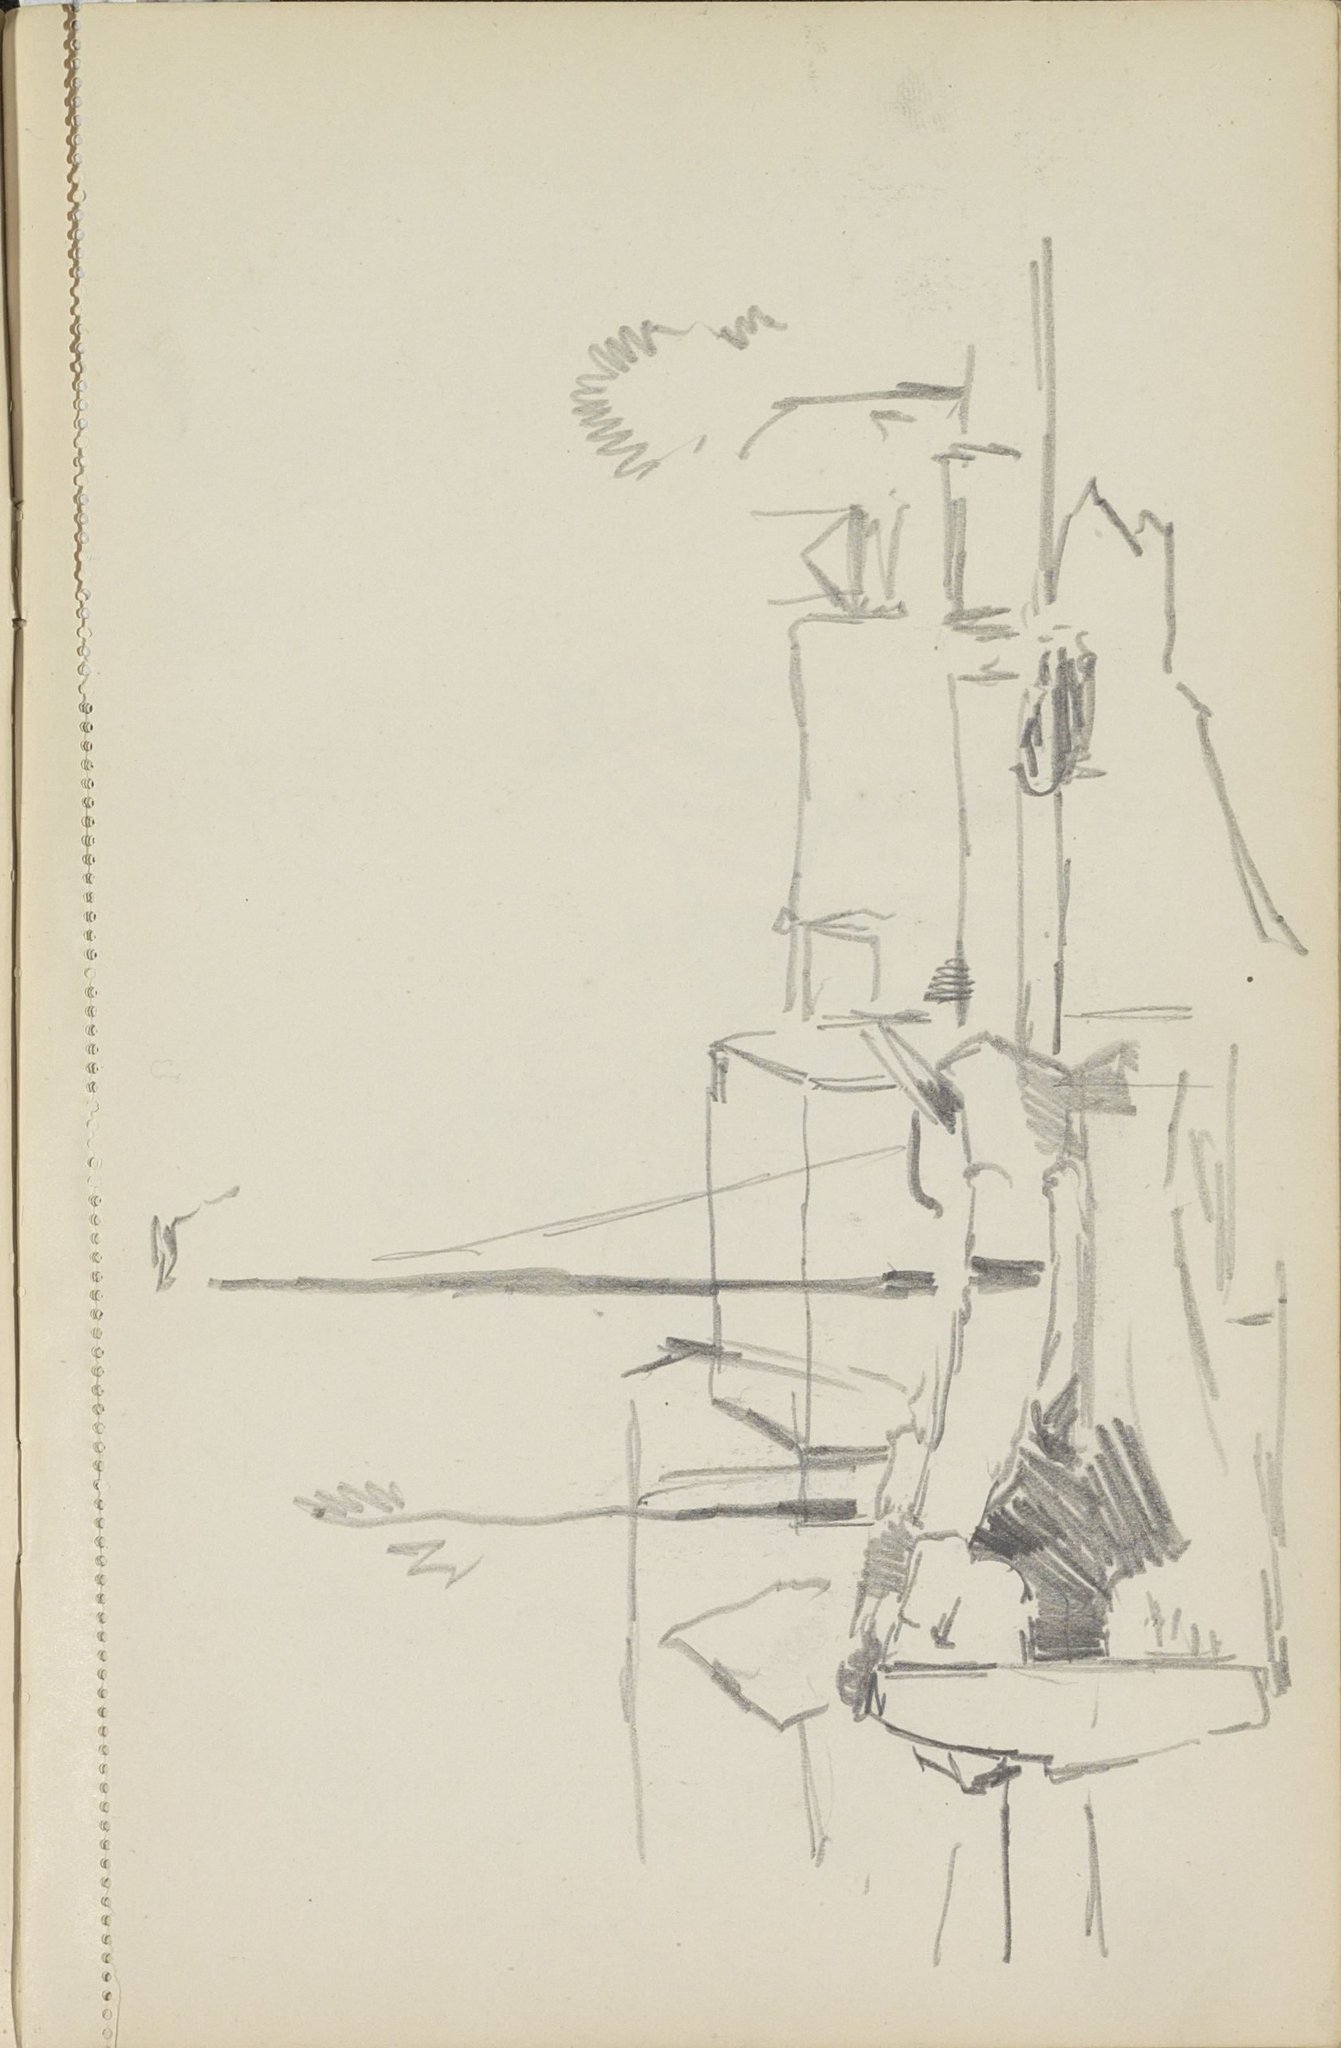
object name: sketchbook leaf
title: Aangemeerde zeilboot aan een kade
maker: cornelis vreedenburgh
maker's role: draughtsman, print maker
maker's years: 1880-1946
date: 1890-1946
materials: paper, pencil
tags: sailing-ship, sailing-boat, quay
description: Blad 34 recto uit een schetsboek met 56 bladen.